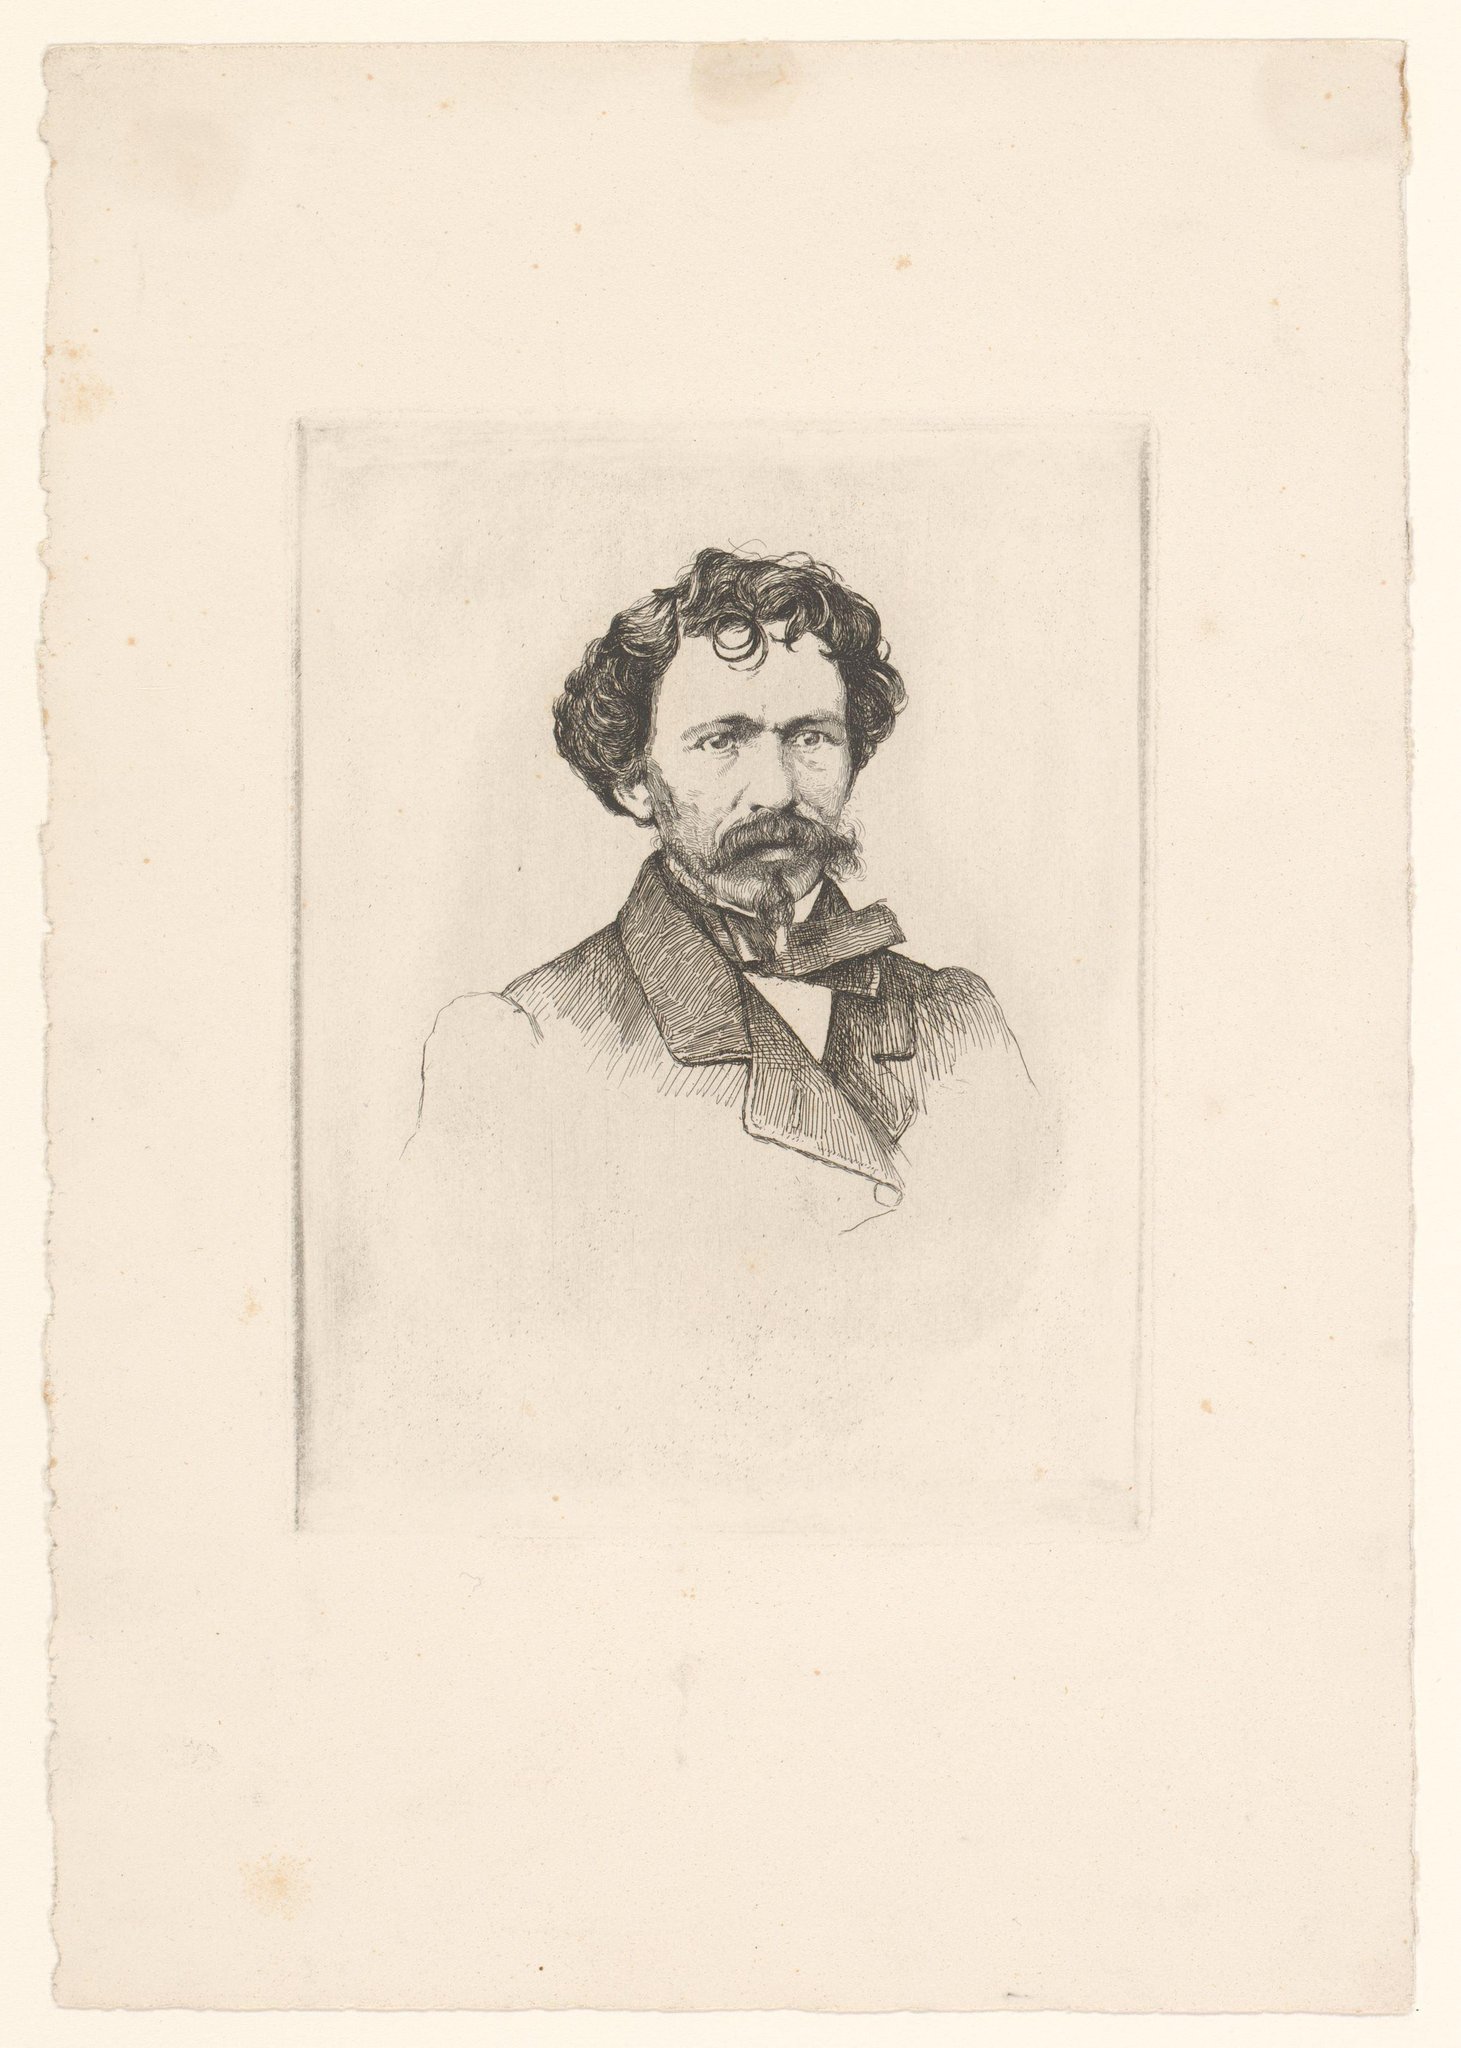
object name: print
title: Portret van Joseph Lies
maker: piet verhaert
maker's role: print maker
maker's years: 1852-1908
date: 1885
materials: paper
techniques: etching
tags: antwerp, joseph lies, adult man, historical persons, beard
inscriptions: collector's mark: Lugt 2228